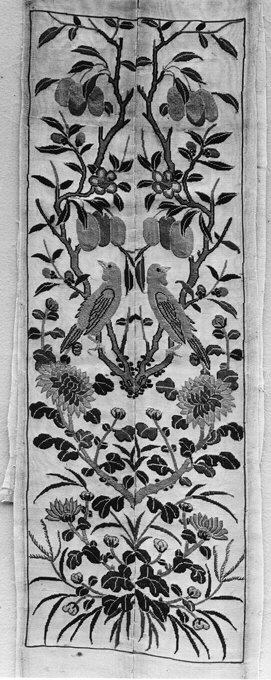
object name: sleeve band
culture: chinese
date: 1801-1900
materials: silk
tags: flowers,leaves,trees